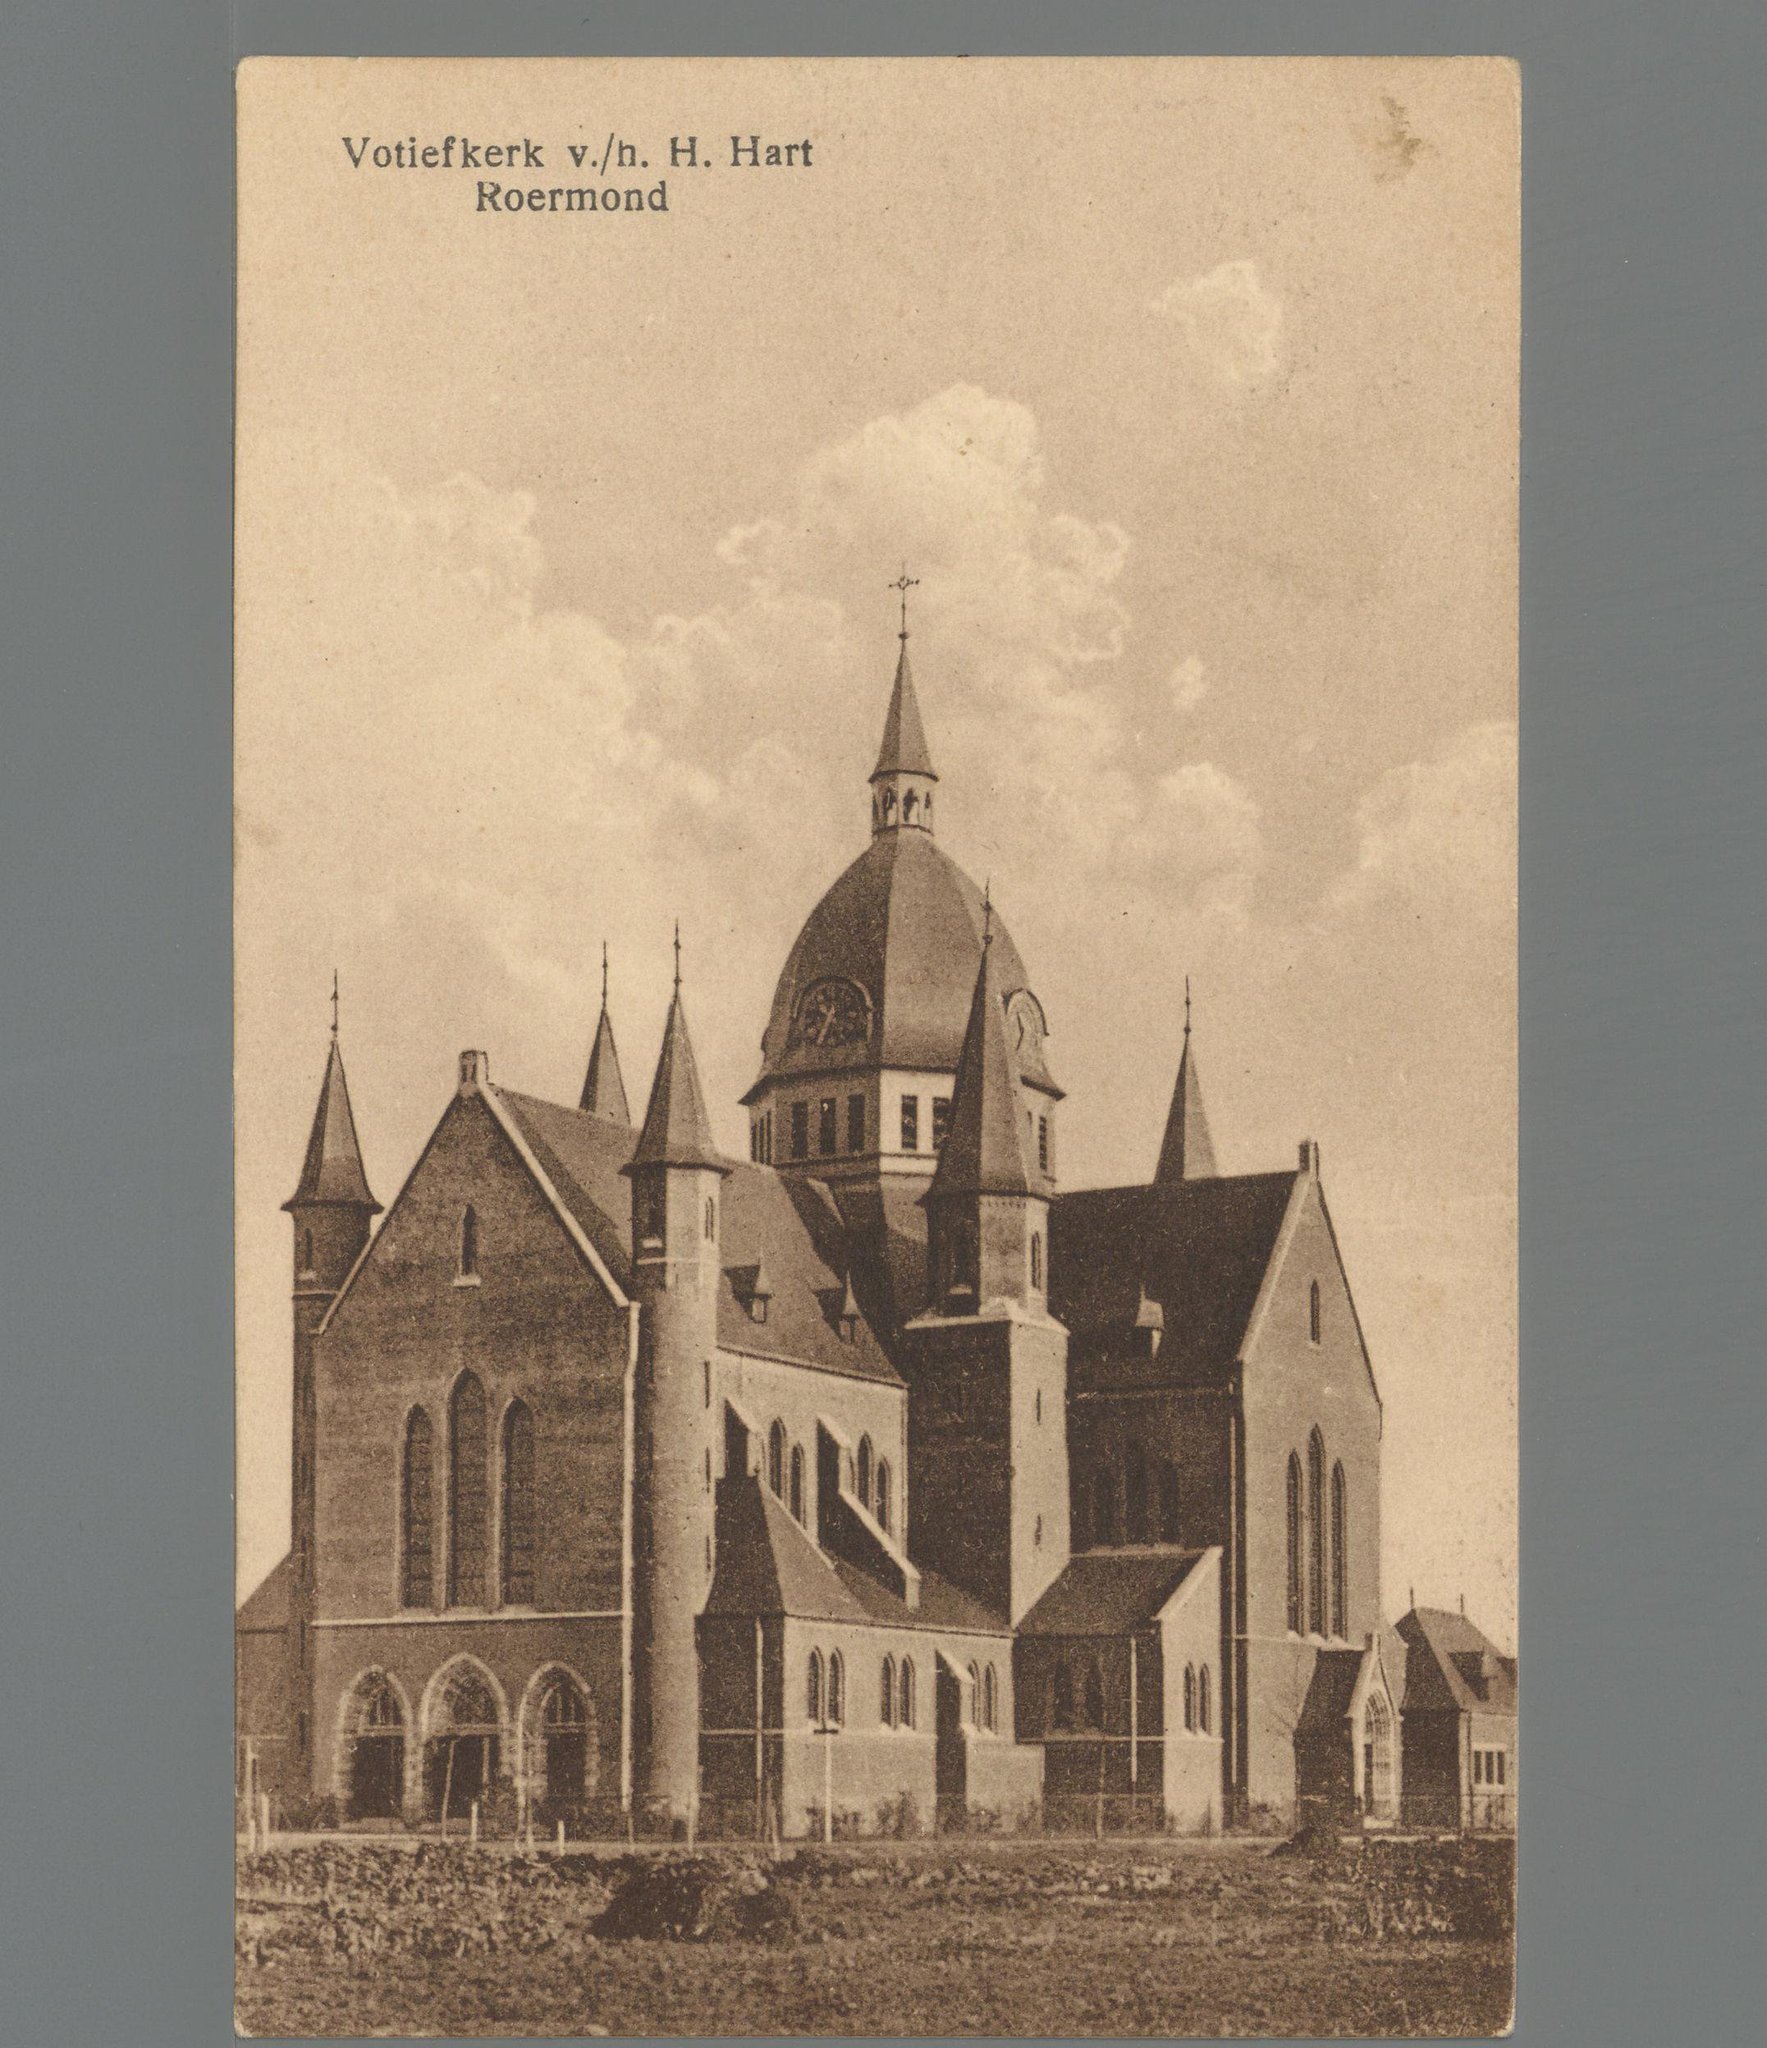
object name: photomechanical print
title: Votiefkerk v./h. H. Hart. Roermond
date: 1905-1928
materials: cardboard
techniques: photograph, writing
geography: roermond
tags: church (exterior)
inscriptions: postage stamp